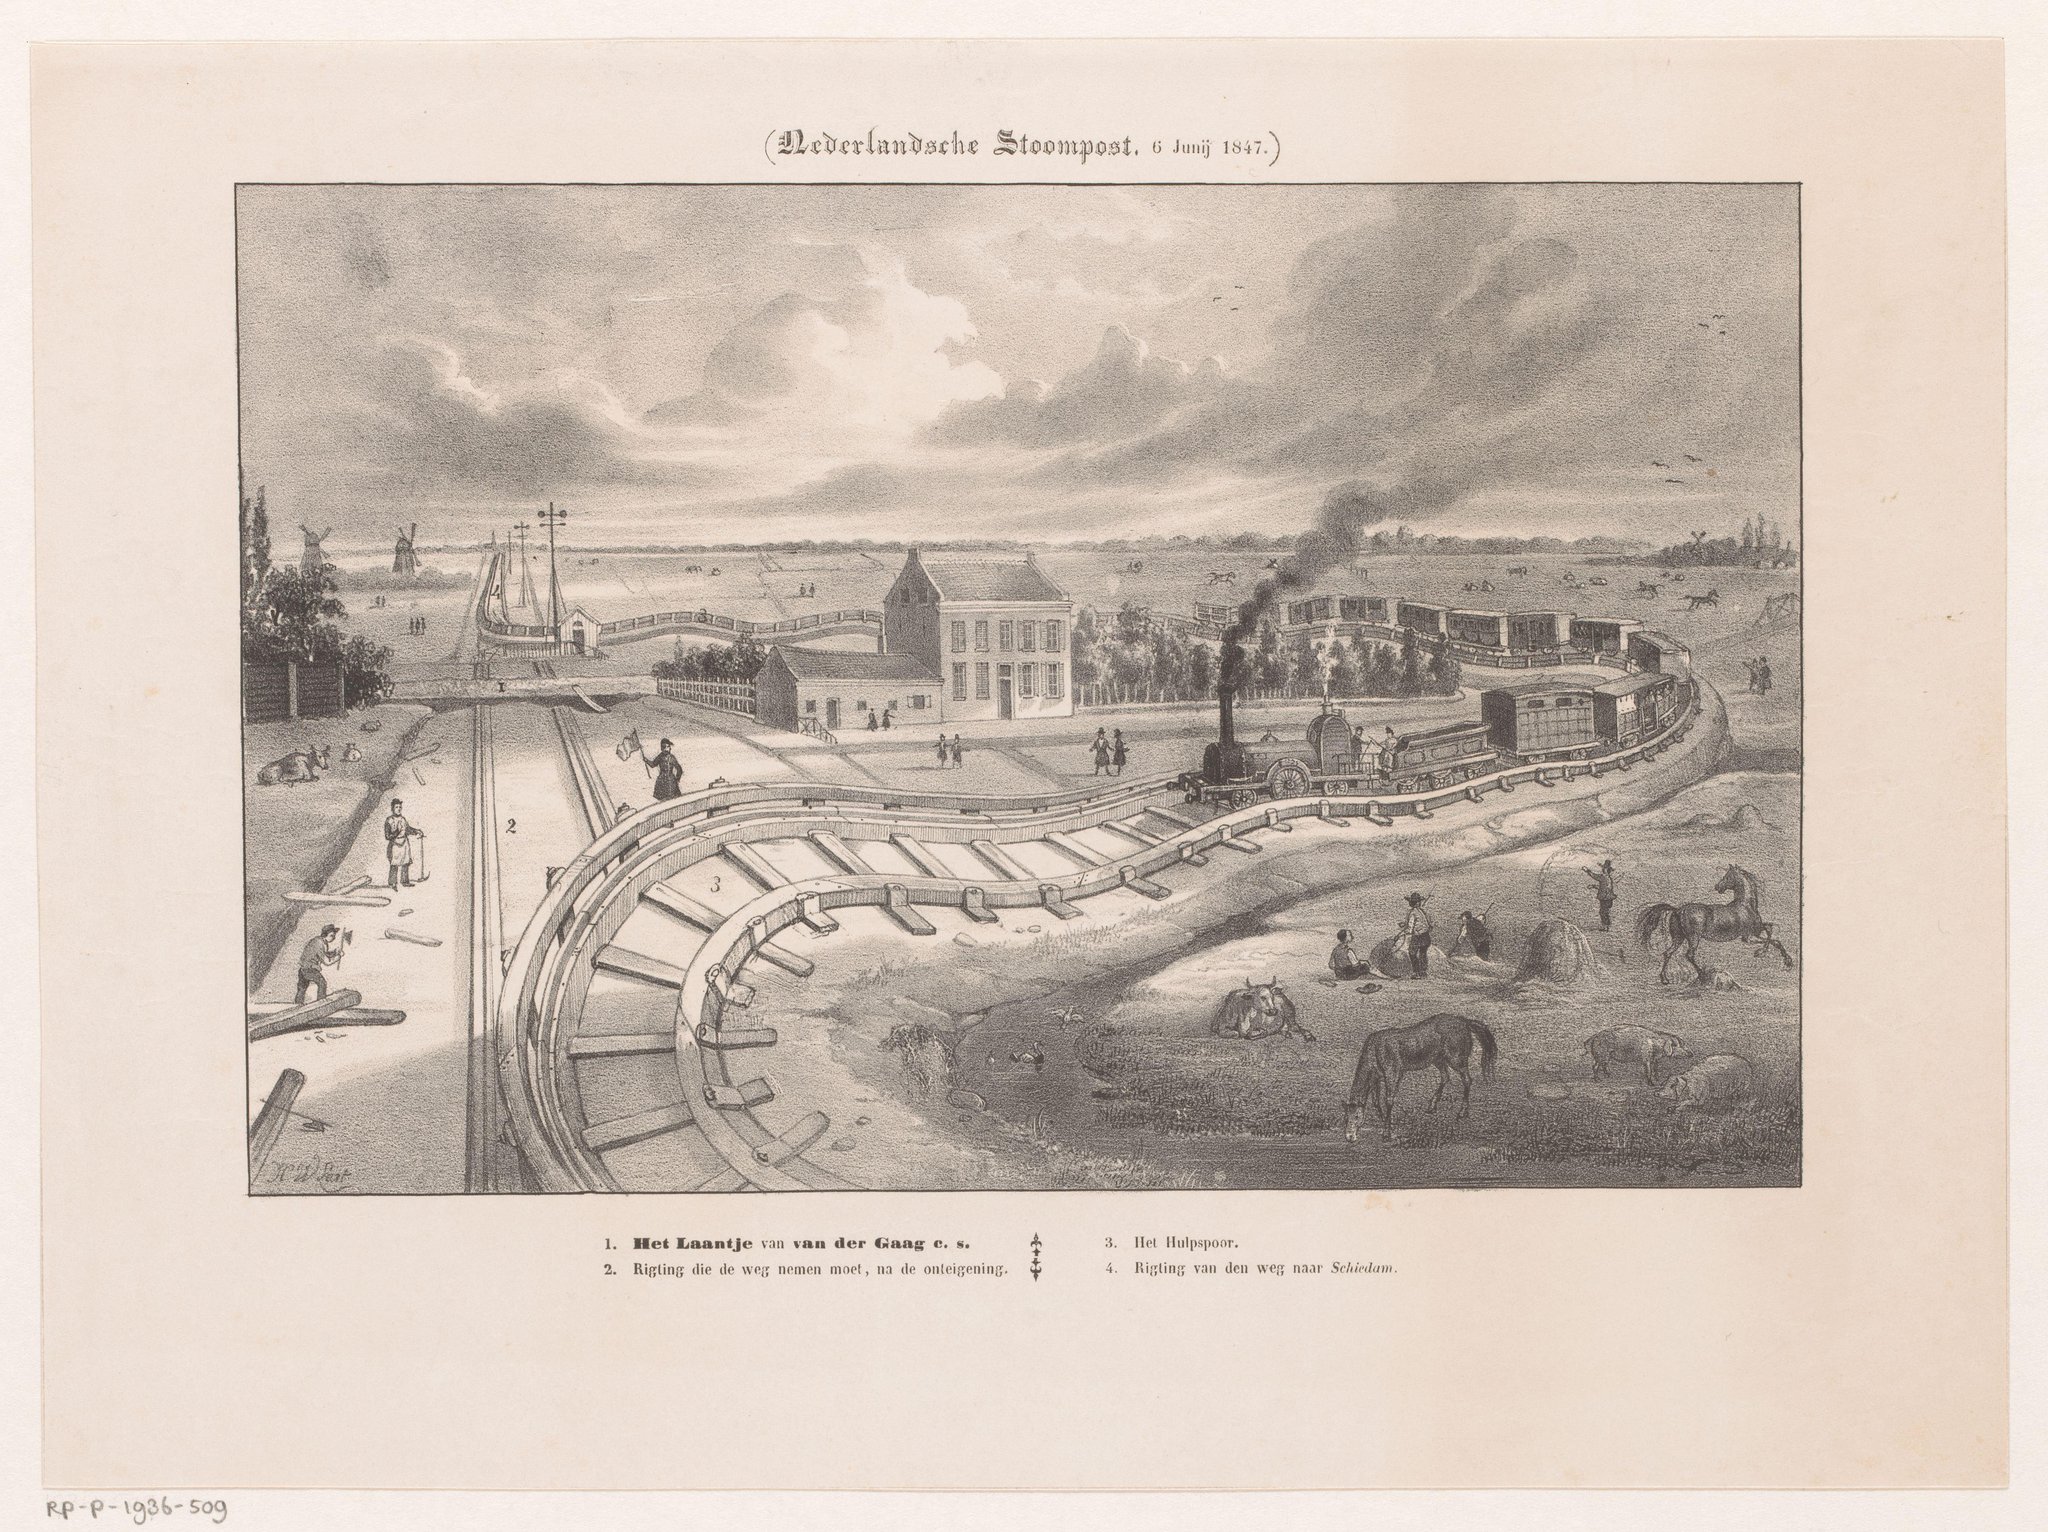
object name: print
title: Tijdelijke spoorweg vanwege het Laantje van Van der Gaag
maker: hendrik wilhelmus last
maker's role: print maker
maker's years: 1817-1873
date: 1847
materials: paper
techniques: lithograph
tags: railway, train, steam locomotive, delft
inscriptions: collector's mark: Lugt 2228, collector's mark: Lugt 2760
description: Met cijfers die corresponderen met onderstaande legenda wordt de situatie toegelicht. Vanwege een conflict met de eigenaar van een stuk grond was de Nederlandse Spoorwegen genoodzaakt een tijdelijk en lusvormig hulpspoor aan te leggen. Op de rails rijdt een stoomtrein.